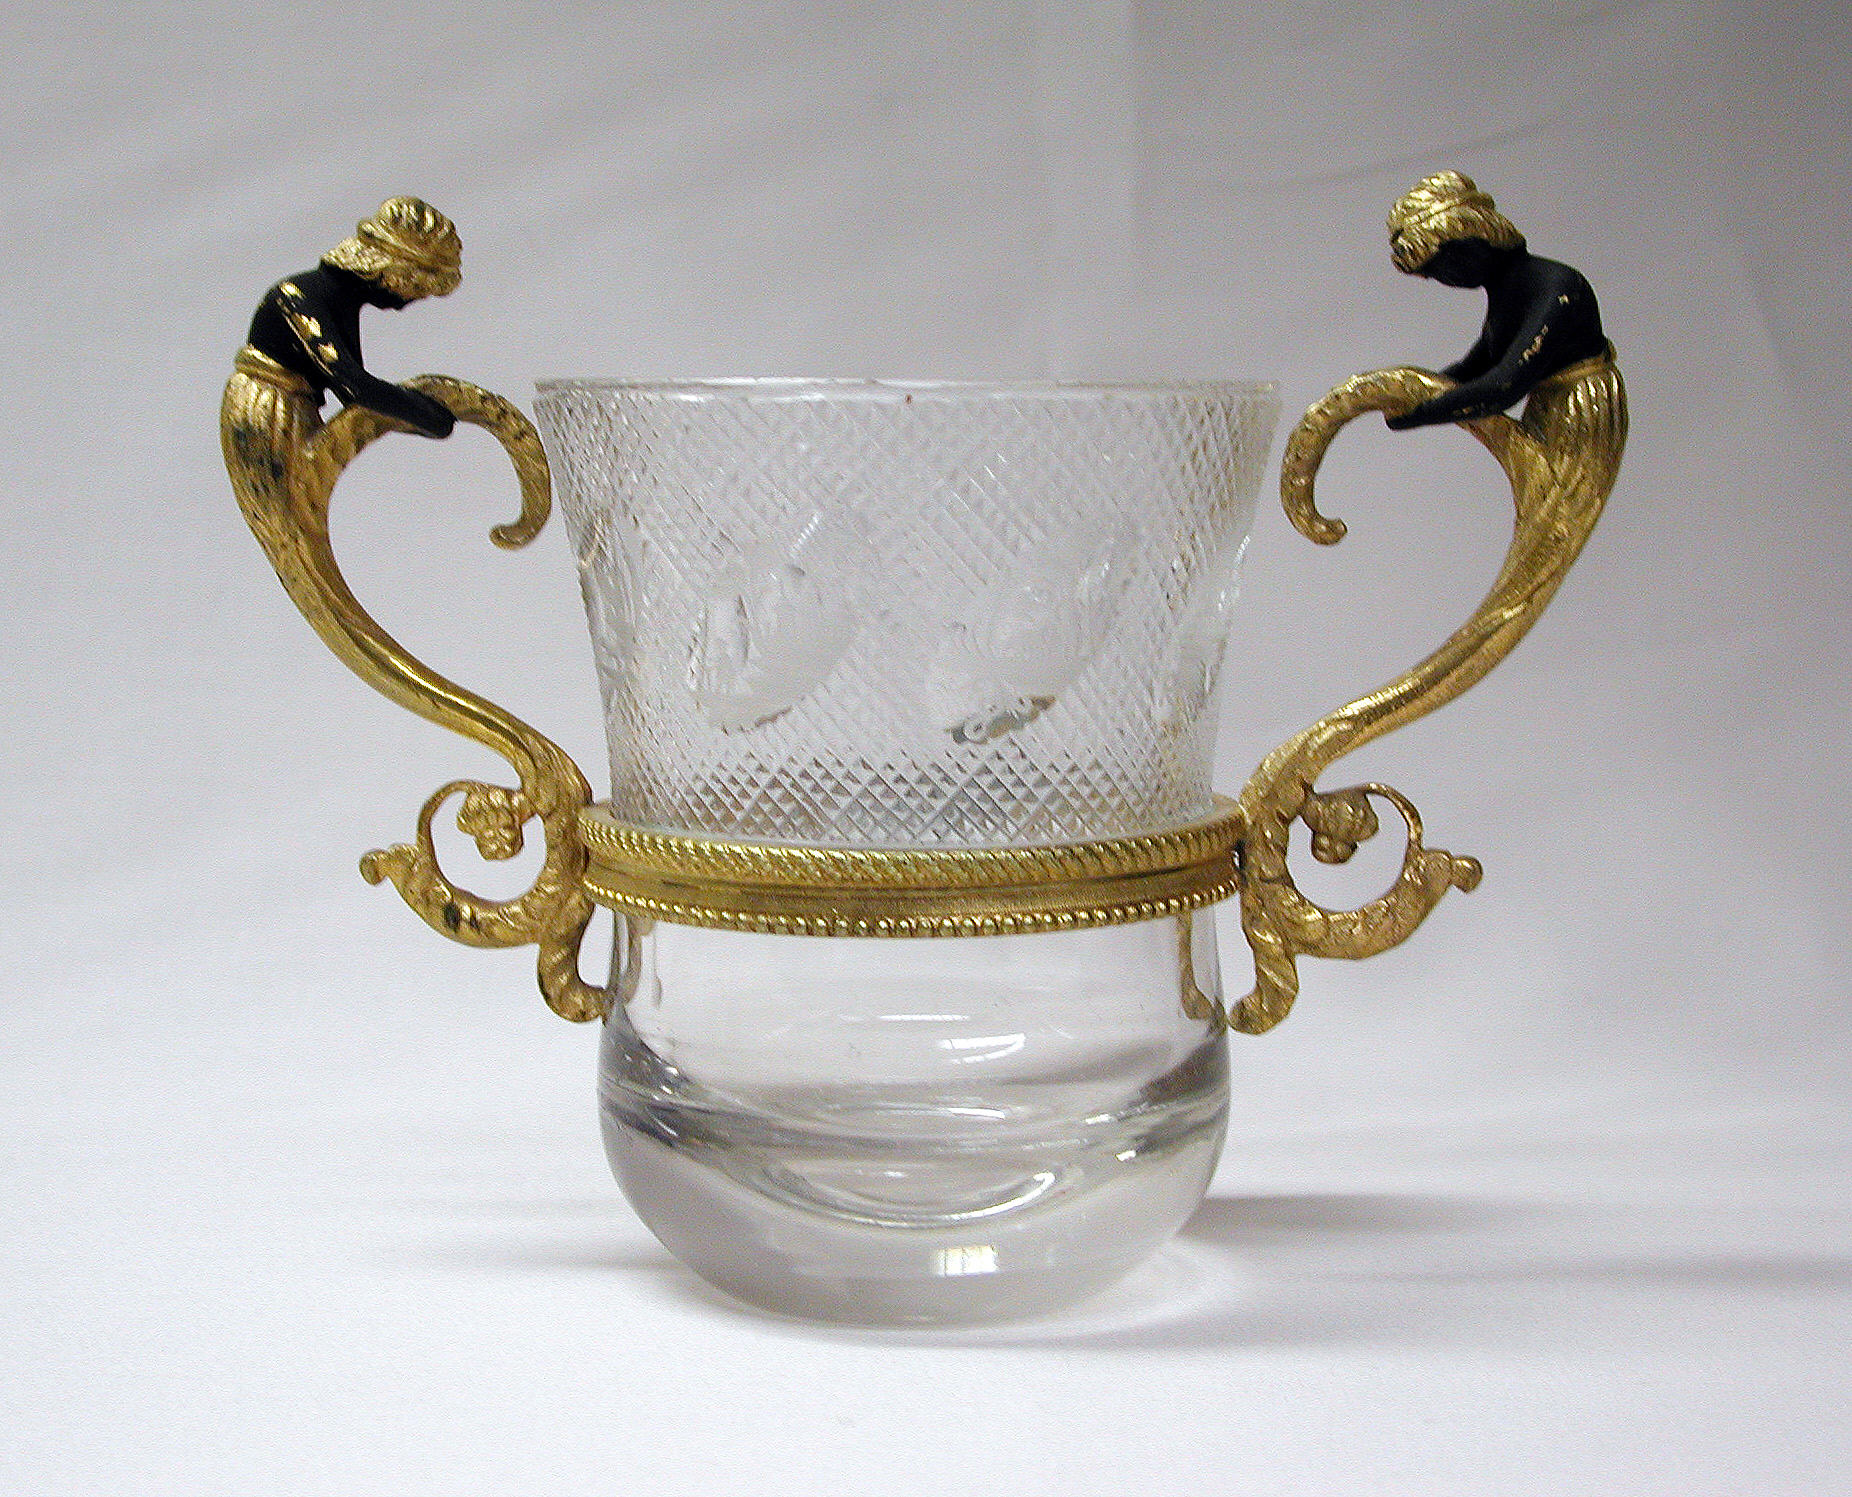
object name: cup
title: Cup with handles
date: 1801-1833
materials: glass